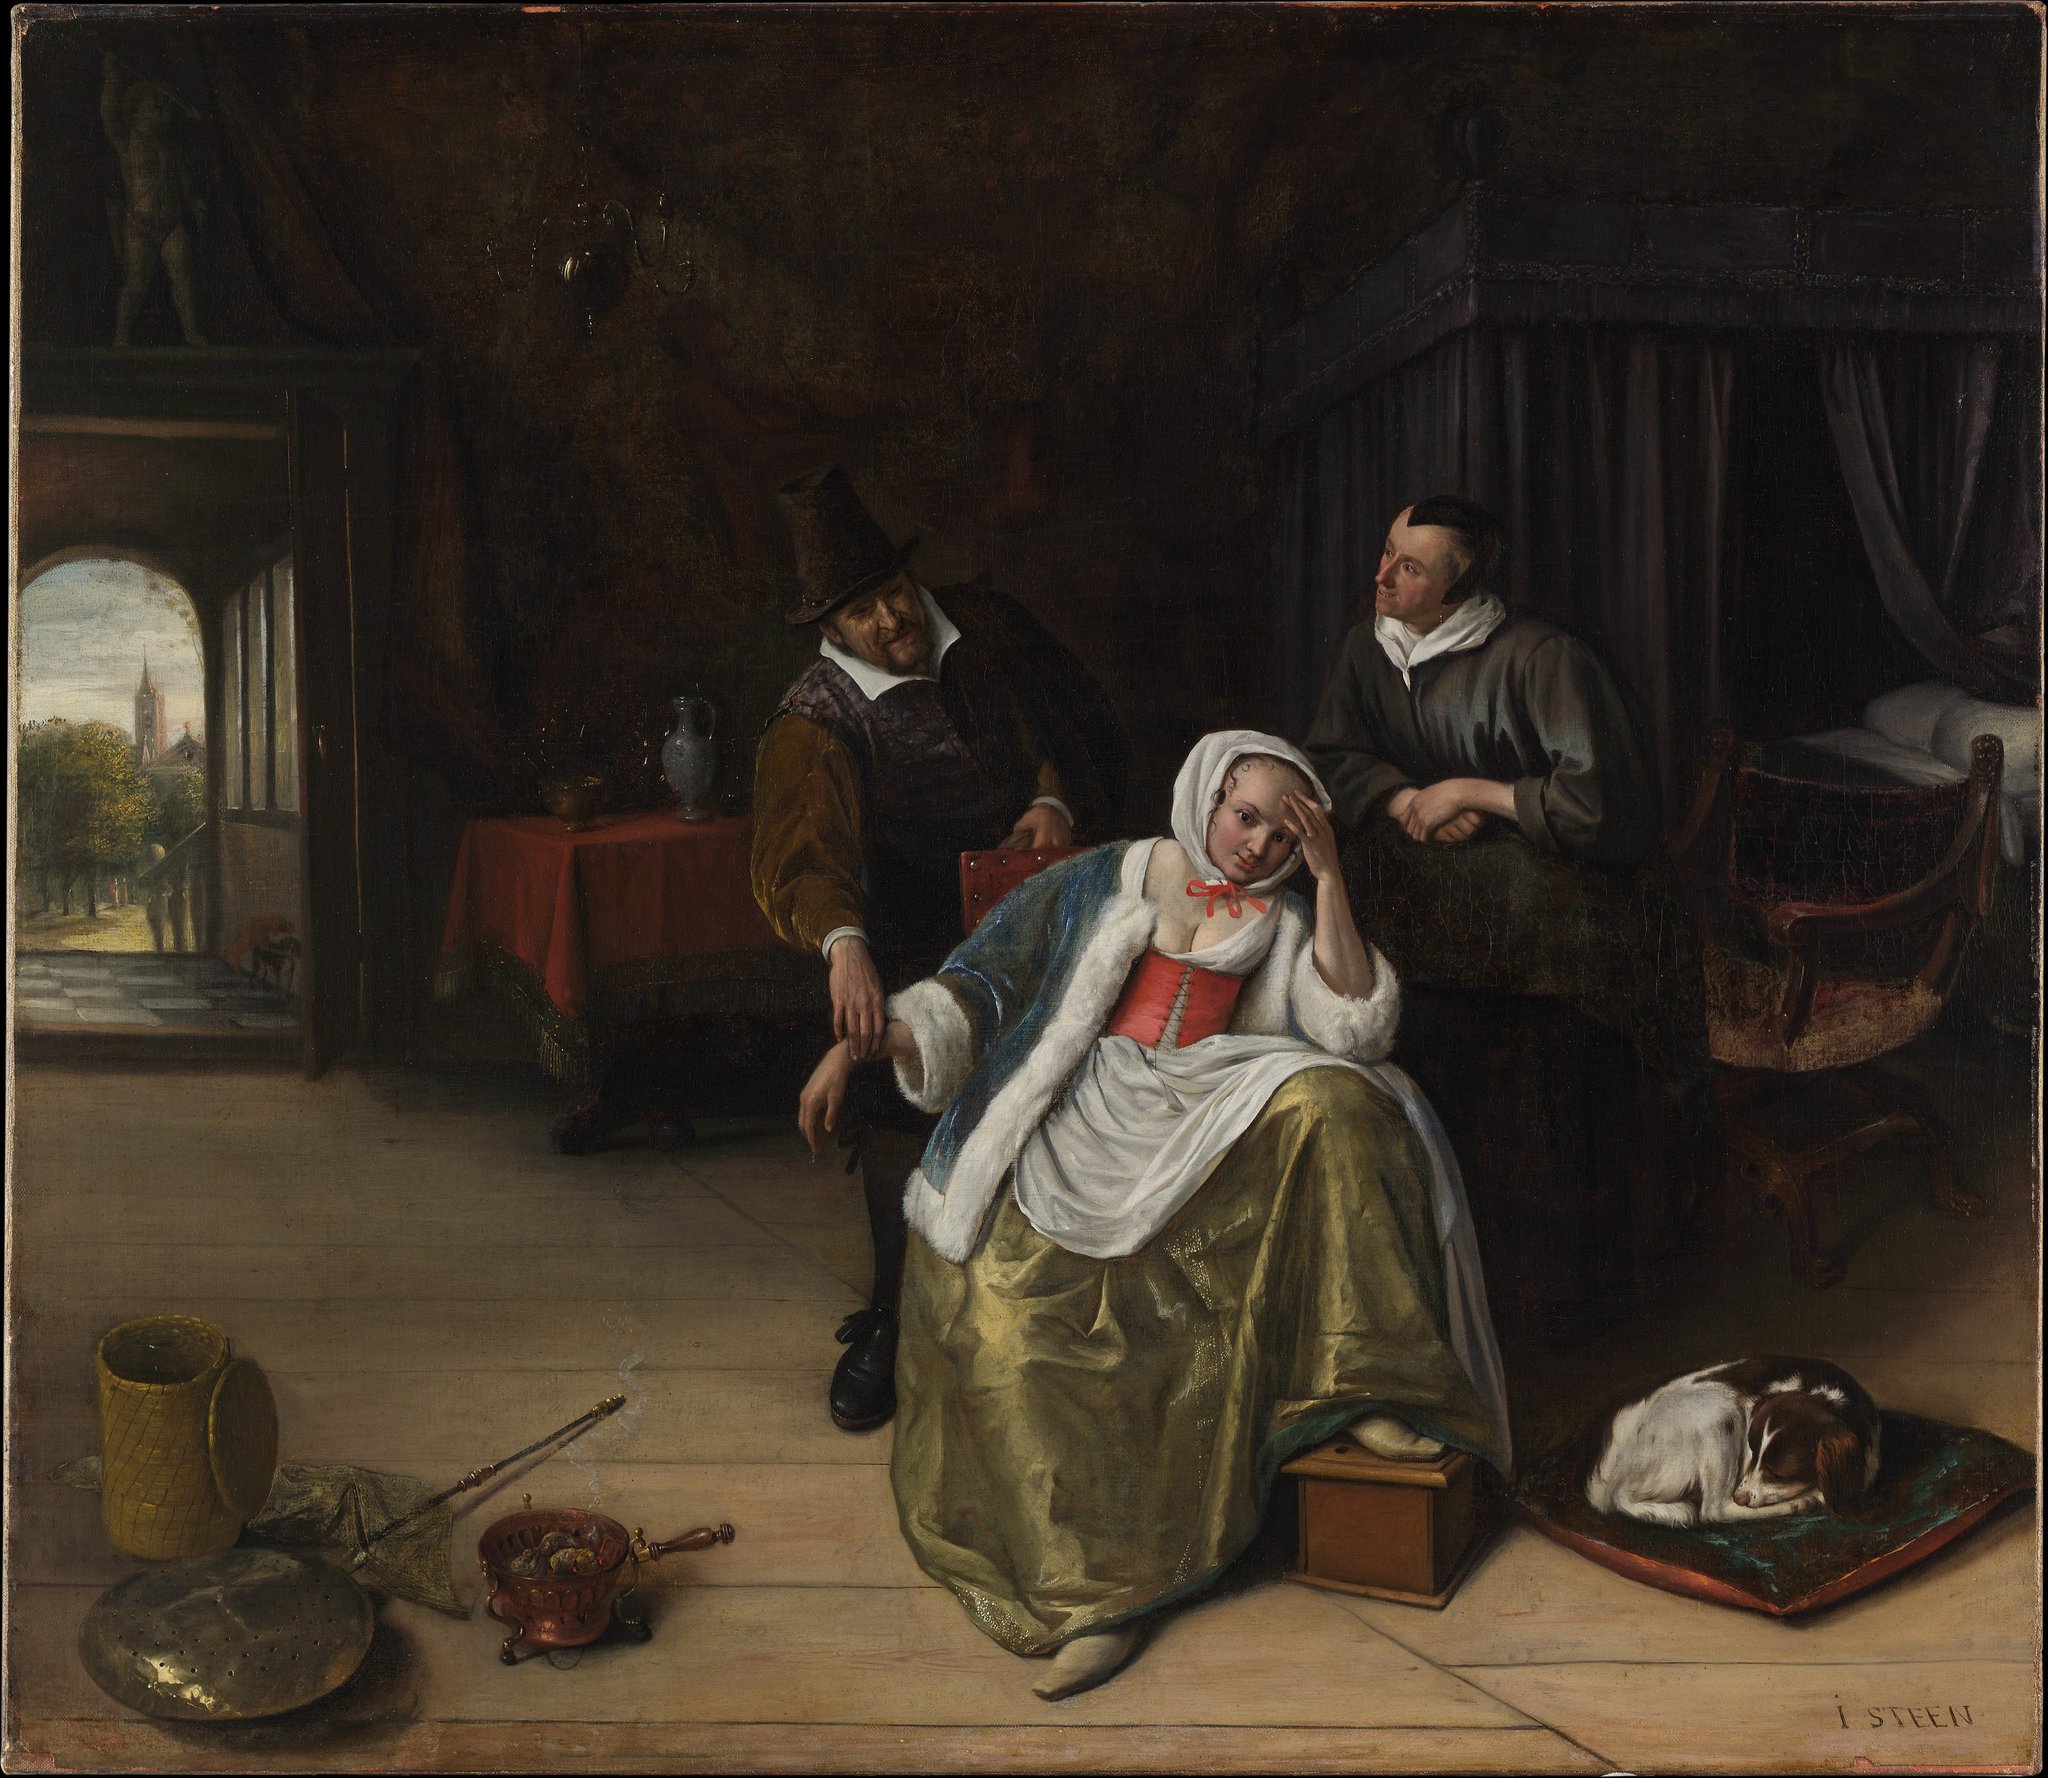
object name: painting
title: The Lovesick Maiden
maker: jan steen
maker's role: artist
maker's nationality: dutch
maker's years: 1626-1679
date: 1660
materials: canvas, oil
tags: interiors,bedrooms,men,women,dogs,beds